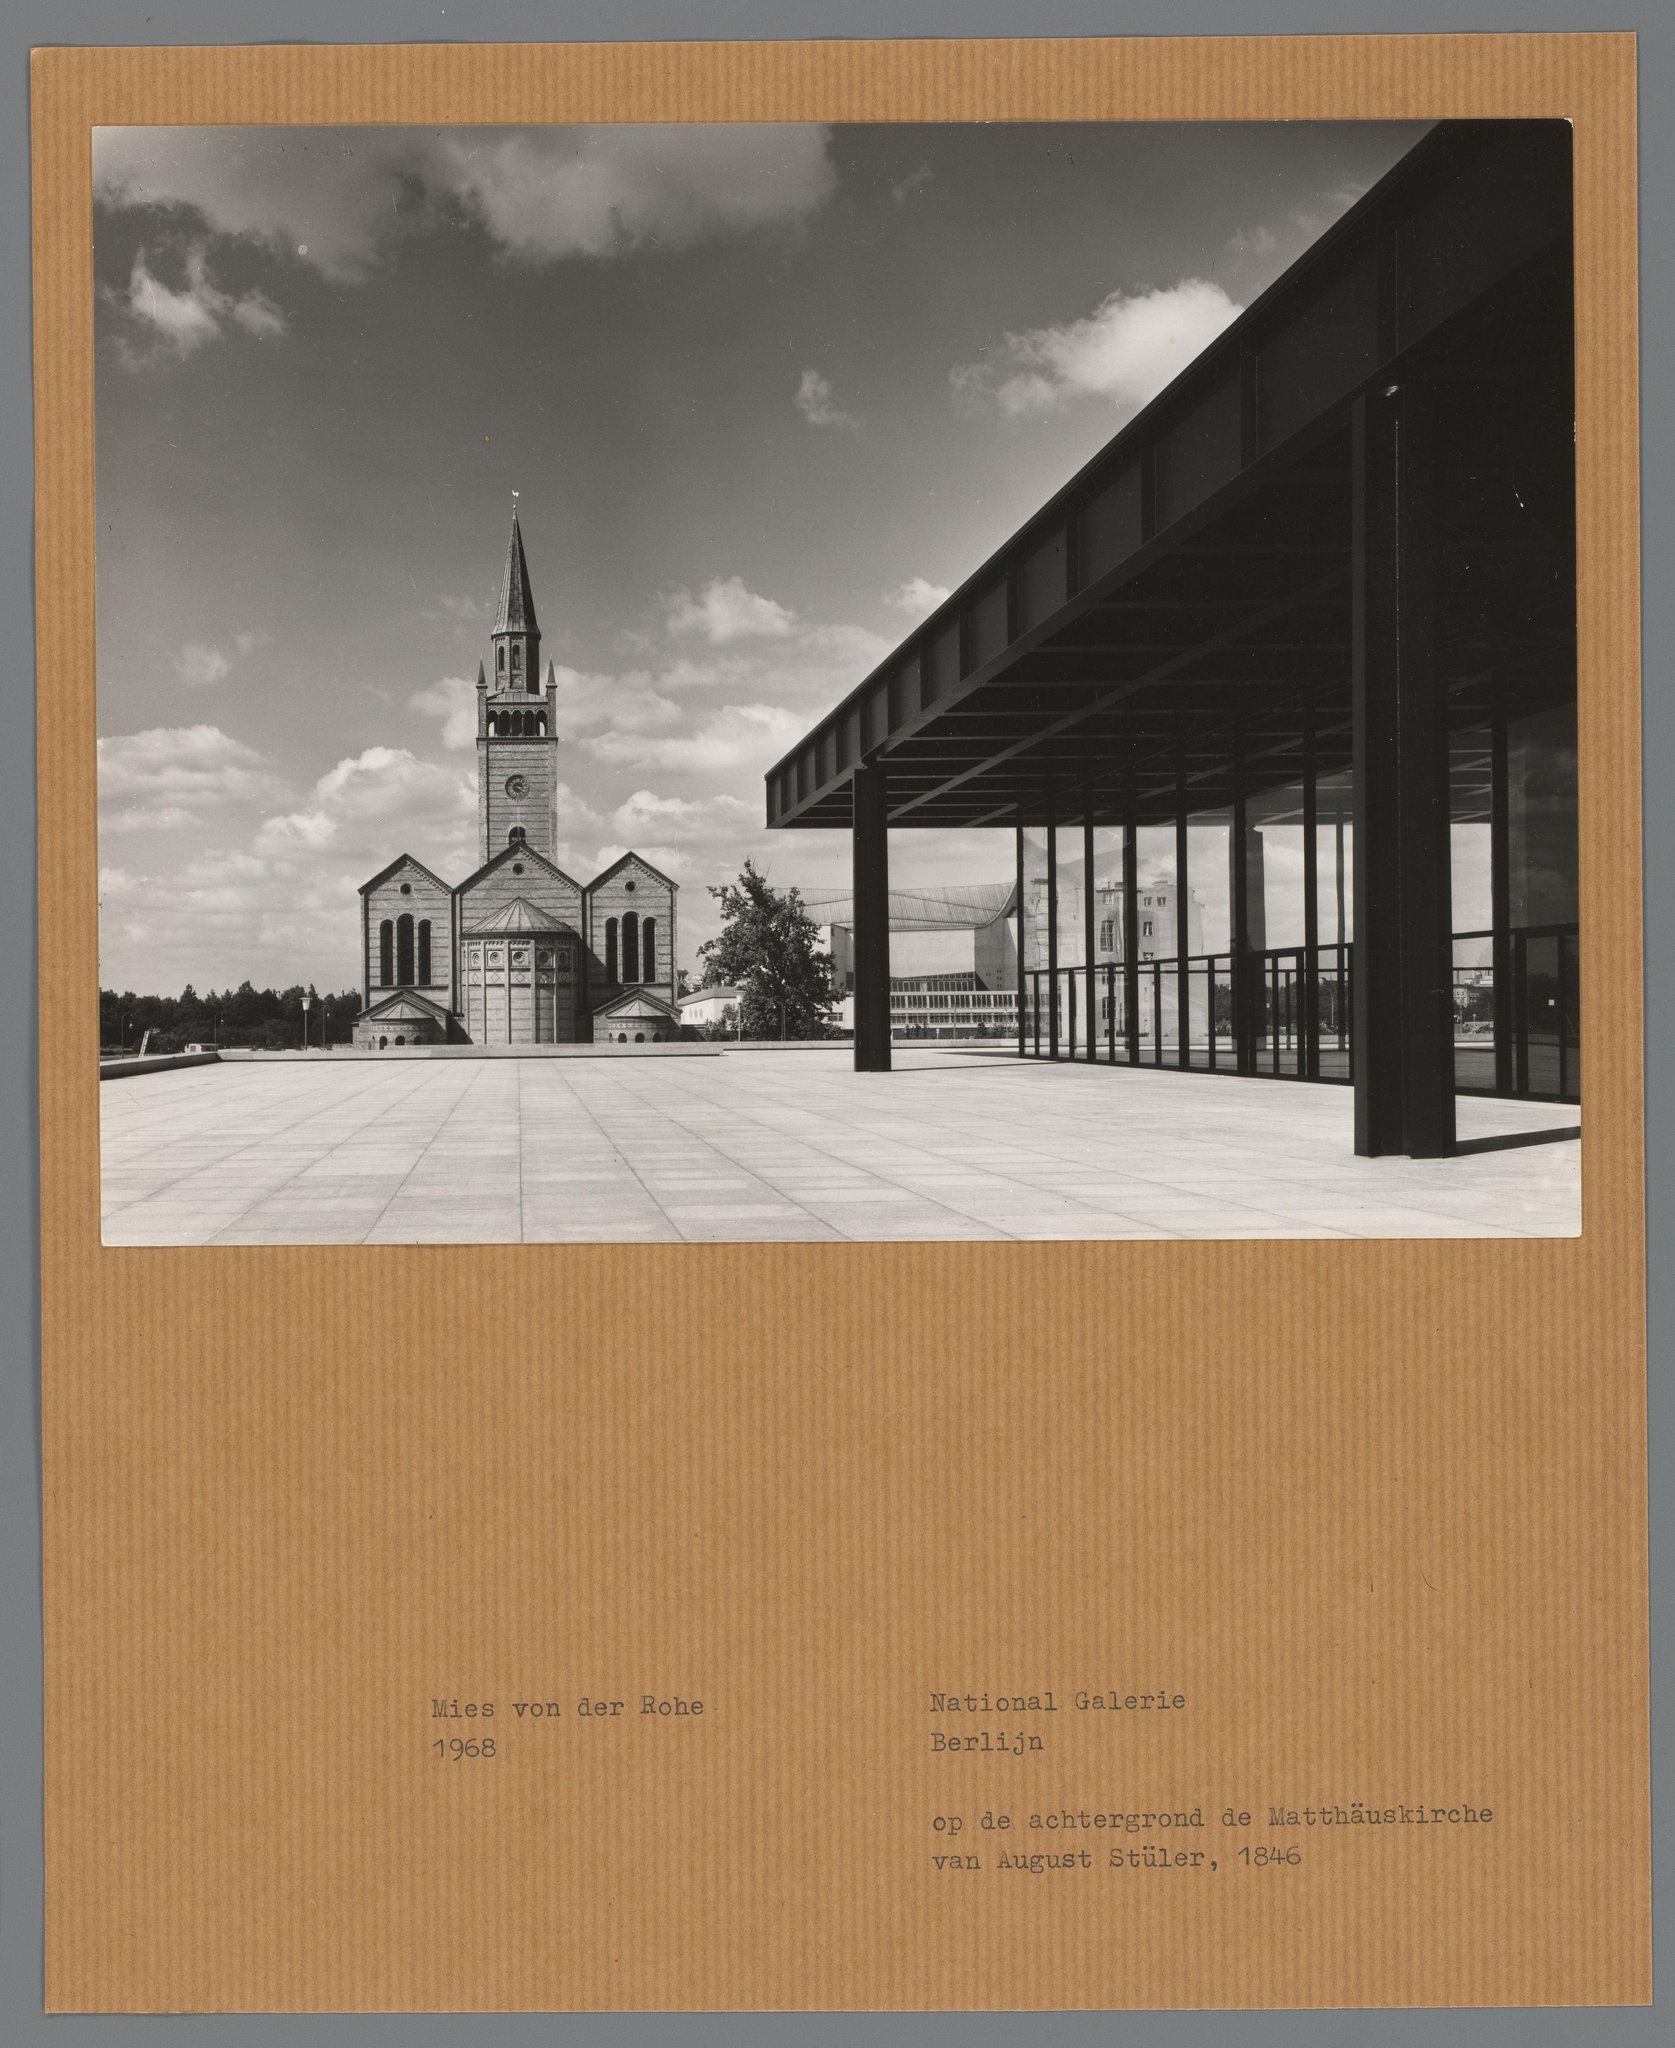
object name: photograph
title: Neue Nationalgalerie van Mies van der Rohe, met Matthäuskirche op de achtergrond, Berlijn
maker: reinhard friedrich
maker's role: fotograaf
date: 1968-1975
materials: photographic support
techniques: gelatin silver print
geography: berlin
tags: moskou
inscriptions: annotation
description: Een foto van Neue Nationalgalerie op drager.